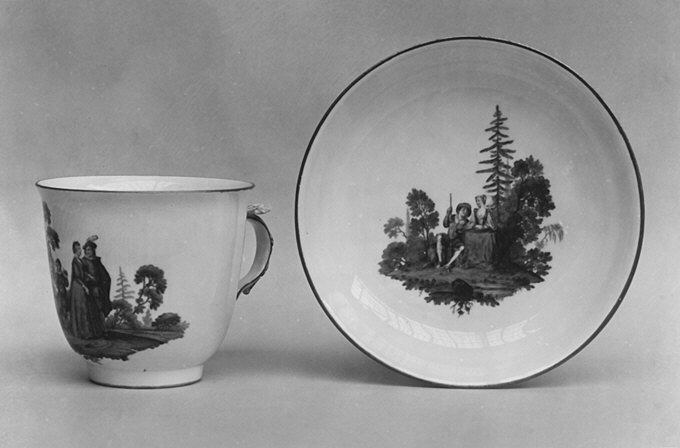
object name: cup and saucer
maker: meissen manufactory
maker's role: manufactory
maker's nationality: german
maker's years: 1710-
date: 1760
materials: hard paste porcelain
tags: men,women,trees